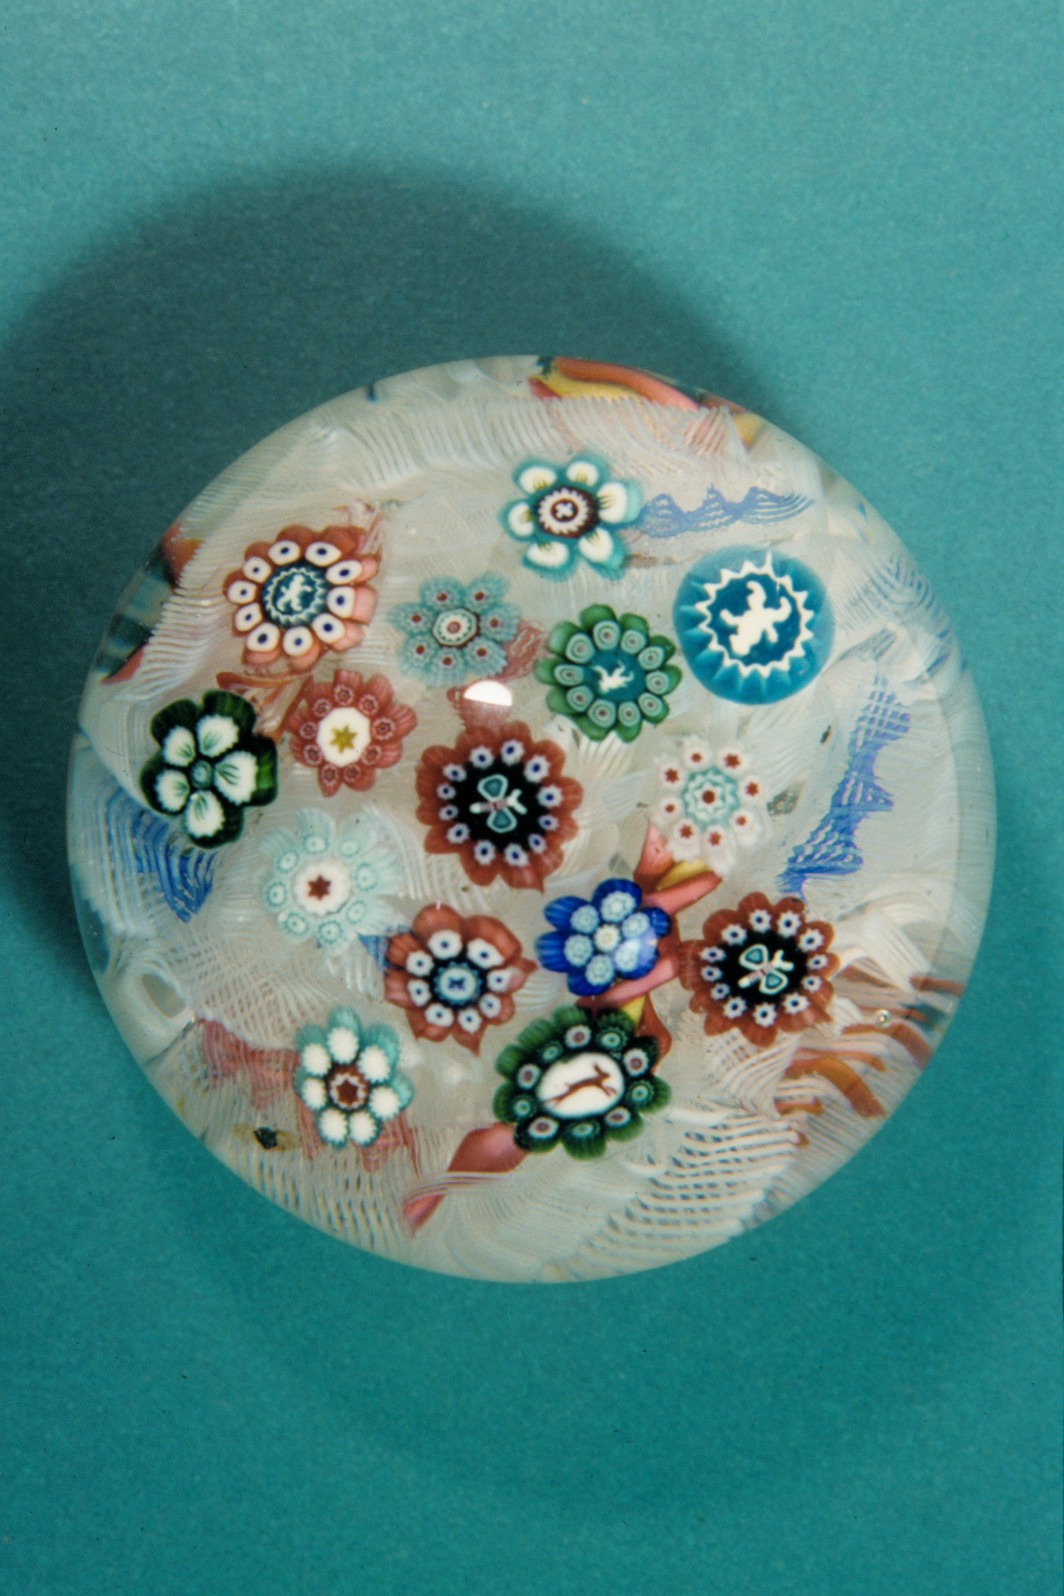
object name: paperweight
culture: american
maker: new england glass company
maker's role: maker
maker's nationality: american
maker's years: 1818-1888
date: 1852-1880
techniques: glassblowing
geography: united states